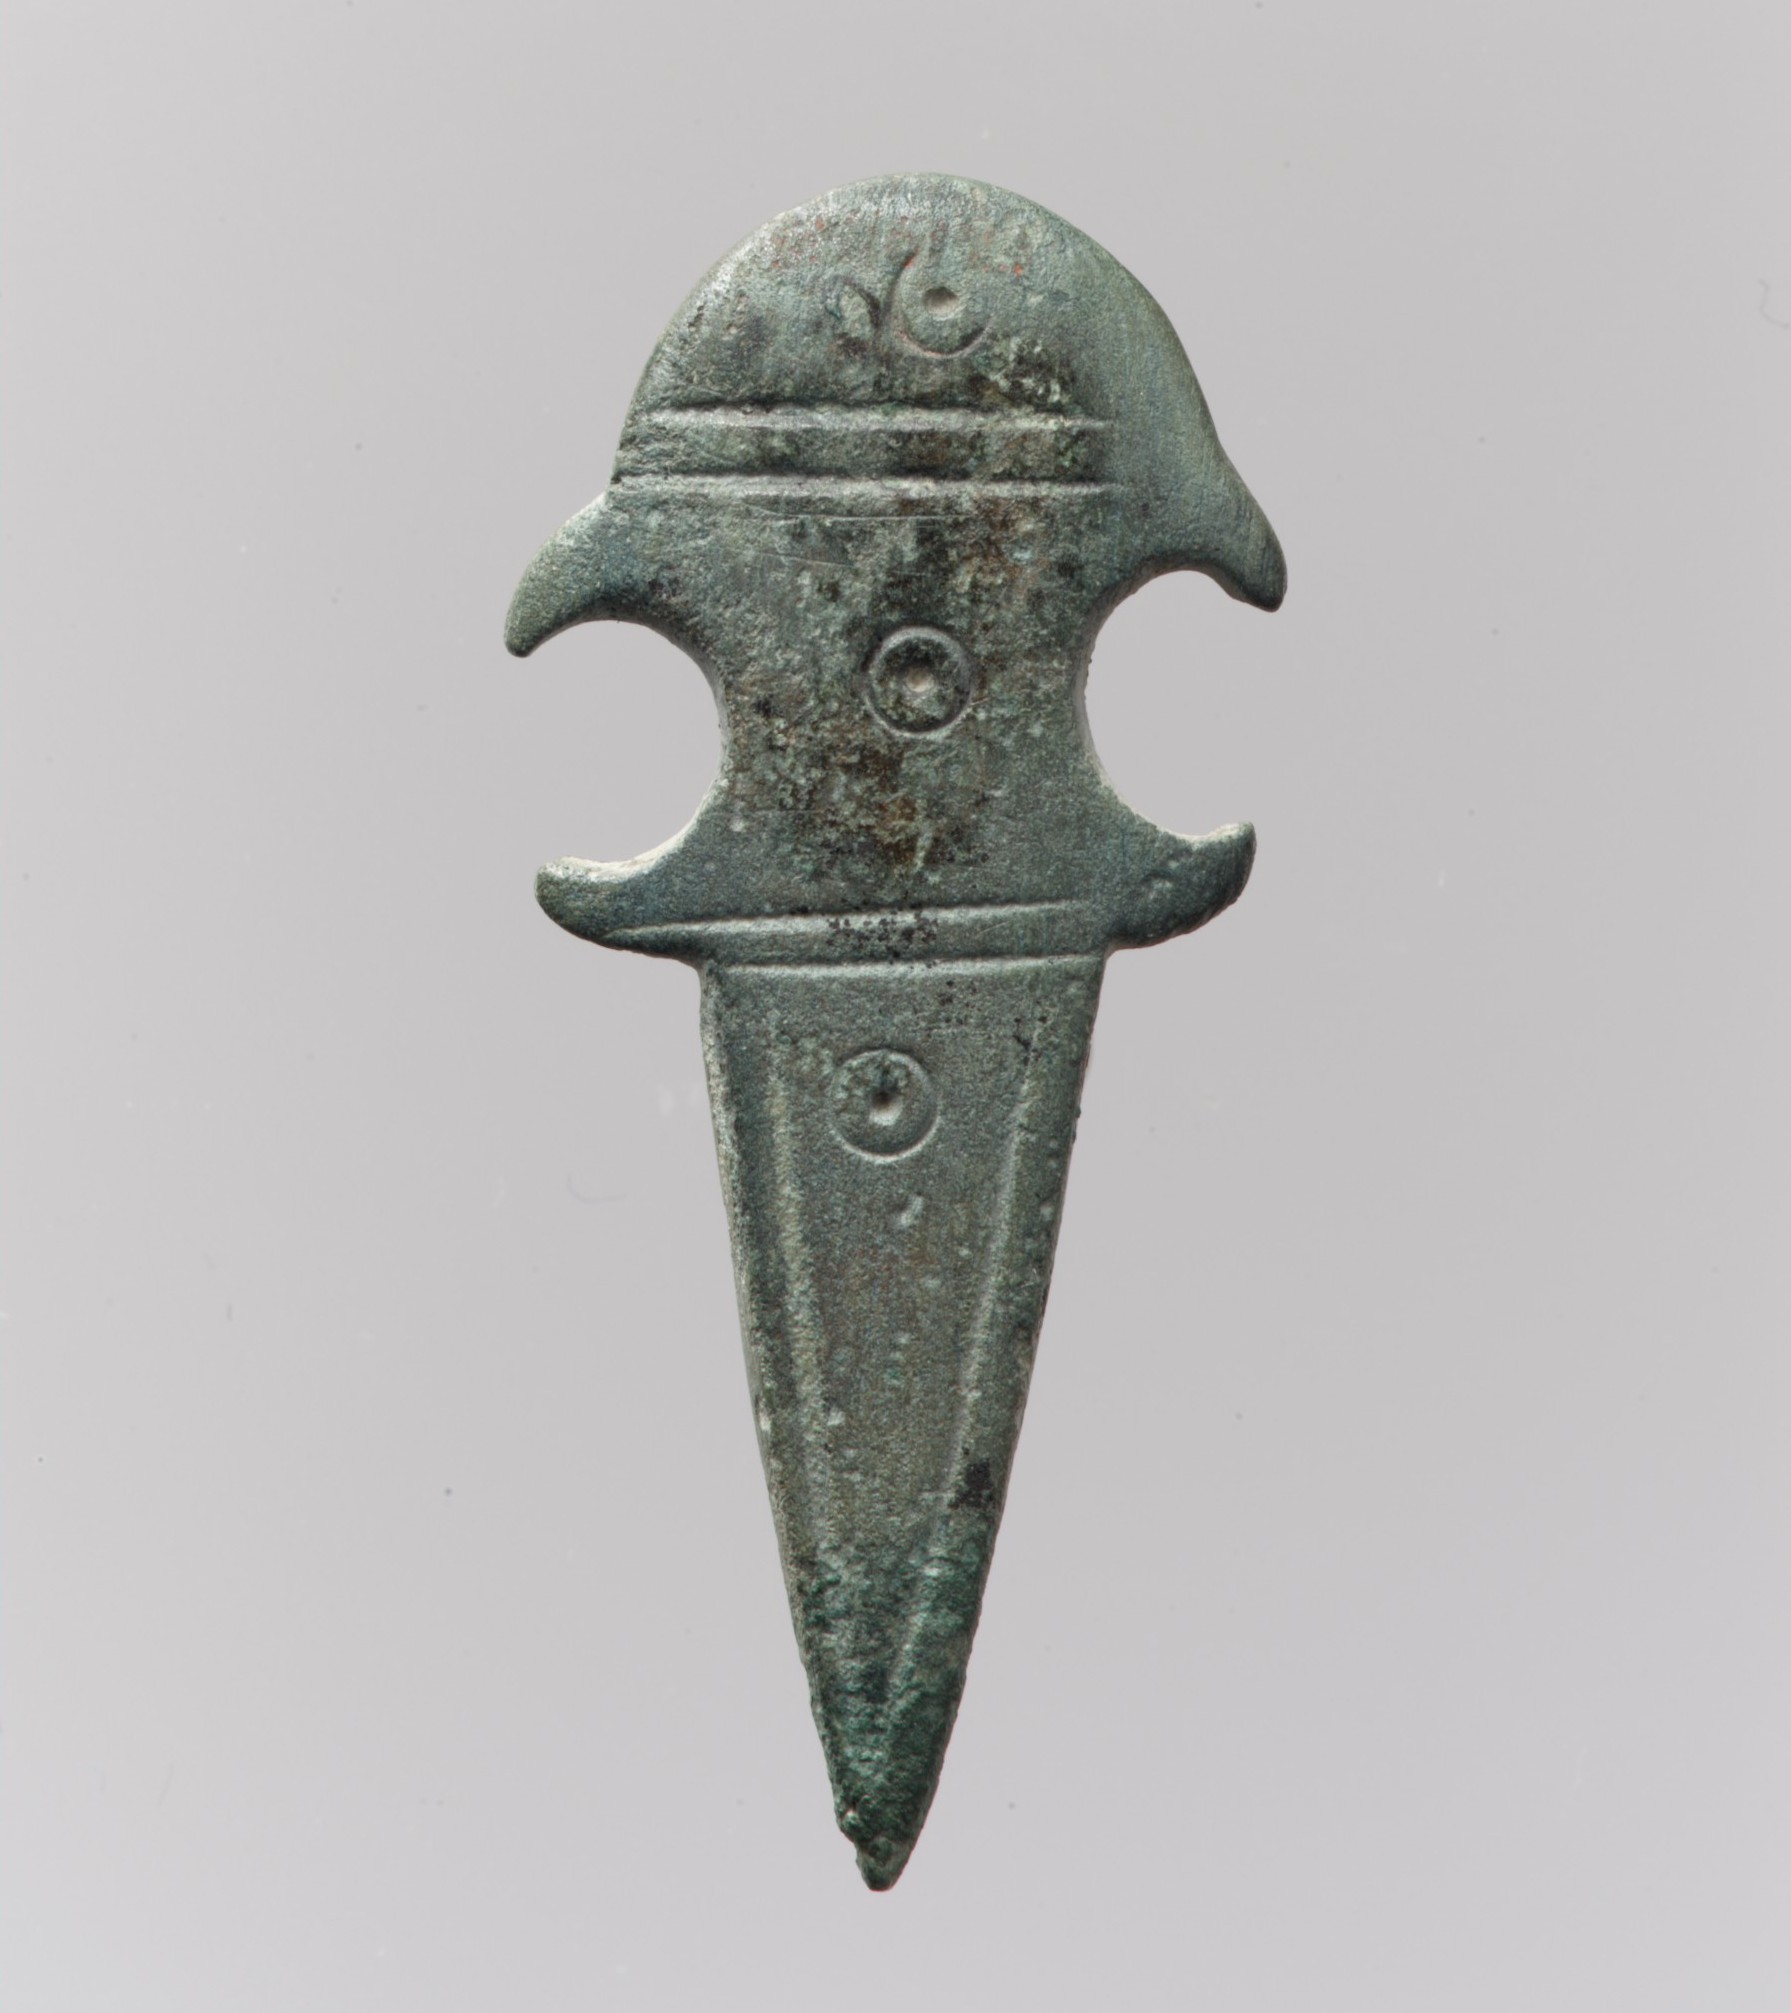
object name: mount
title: Belt Mount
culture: frankish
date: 501-600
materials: copper alloy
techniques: casting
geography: western france